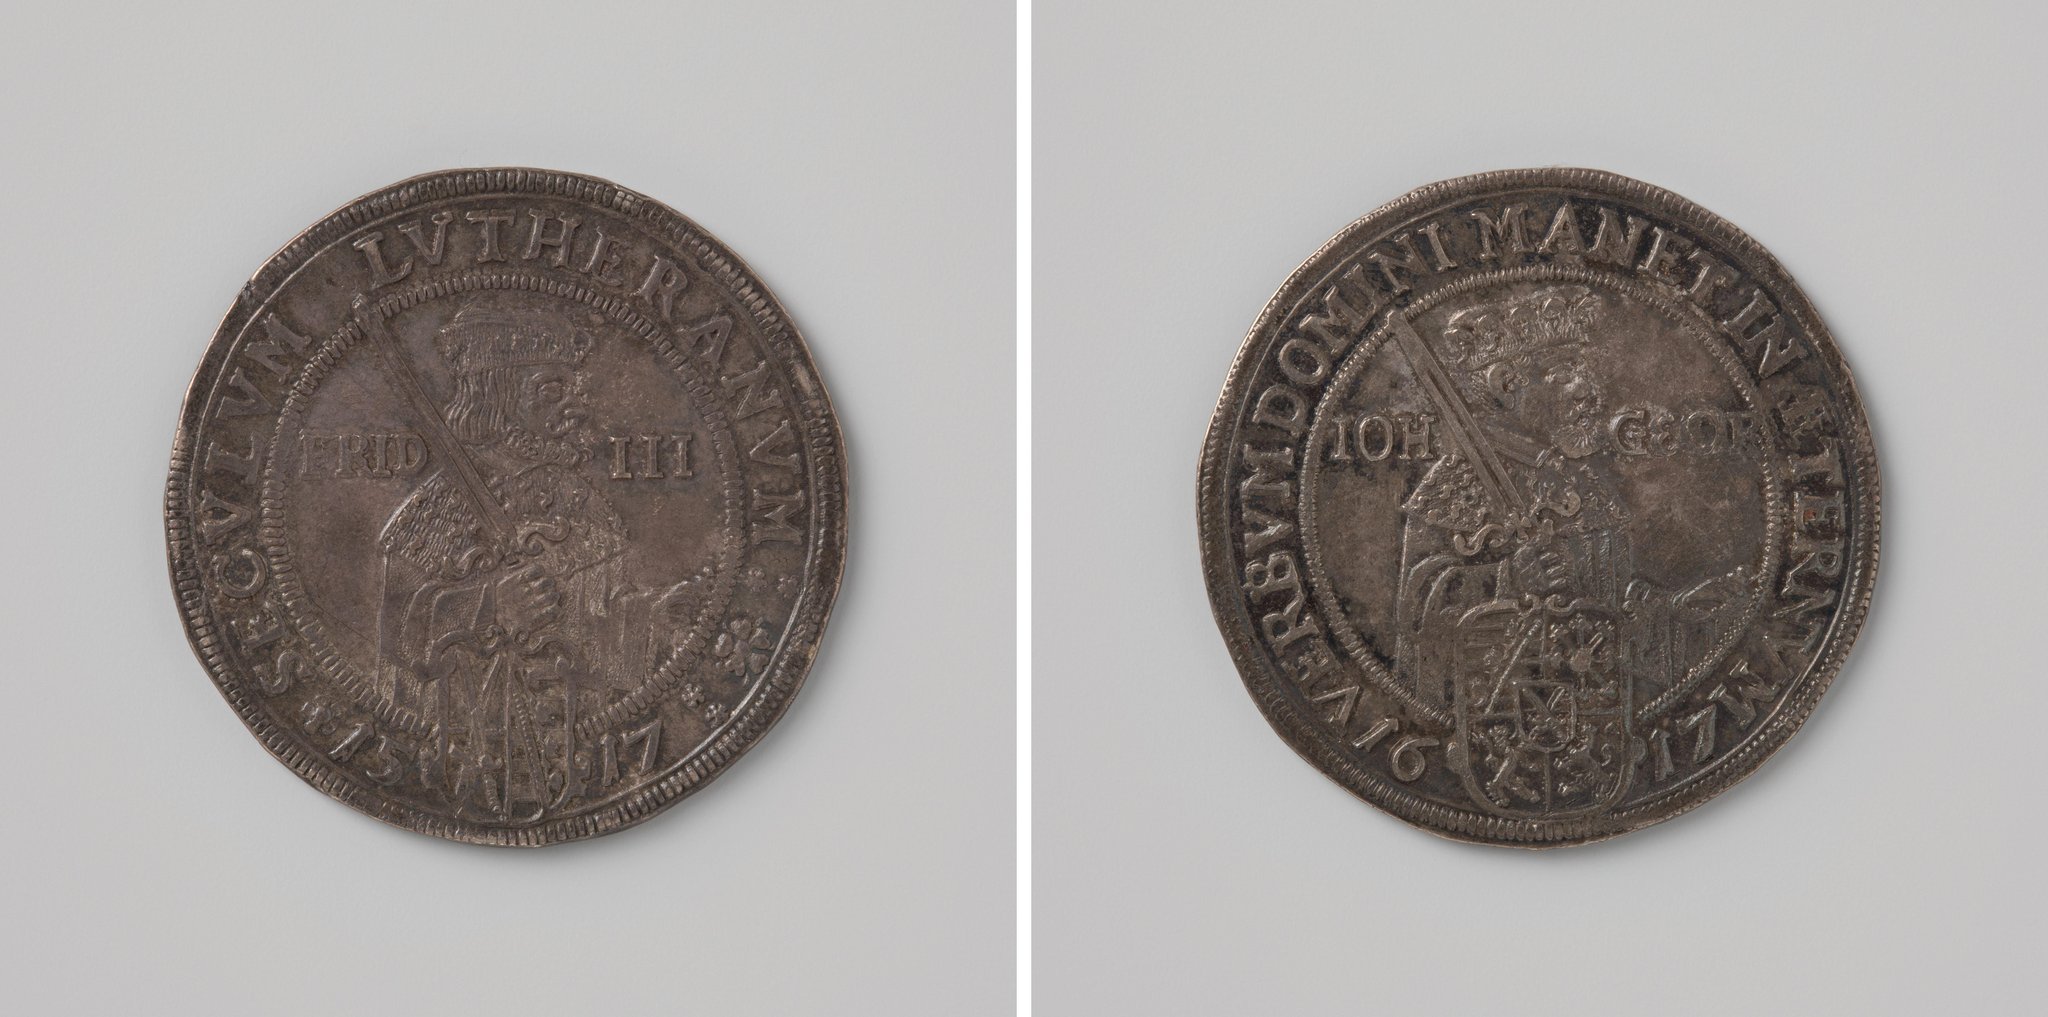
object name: history medal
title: Eerste eeuwfeest van de Reformatie door Martin Luther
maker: heinrich von rehnen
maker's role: medailleur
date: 1617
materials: silver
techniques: striking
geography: dresden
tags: johann george van saksen (i)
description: Zilveren penning. Voorzijde: portret van man met zwaard over rechter schouder (Frederik III). Keerzijde: portret van man met zwaard over rechter schouder (Johan Georg).